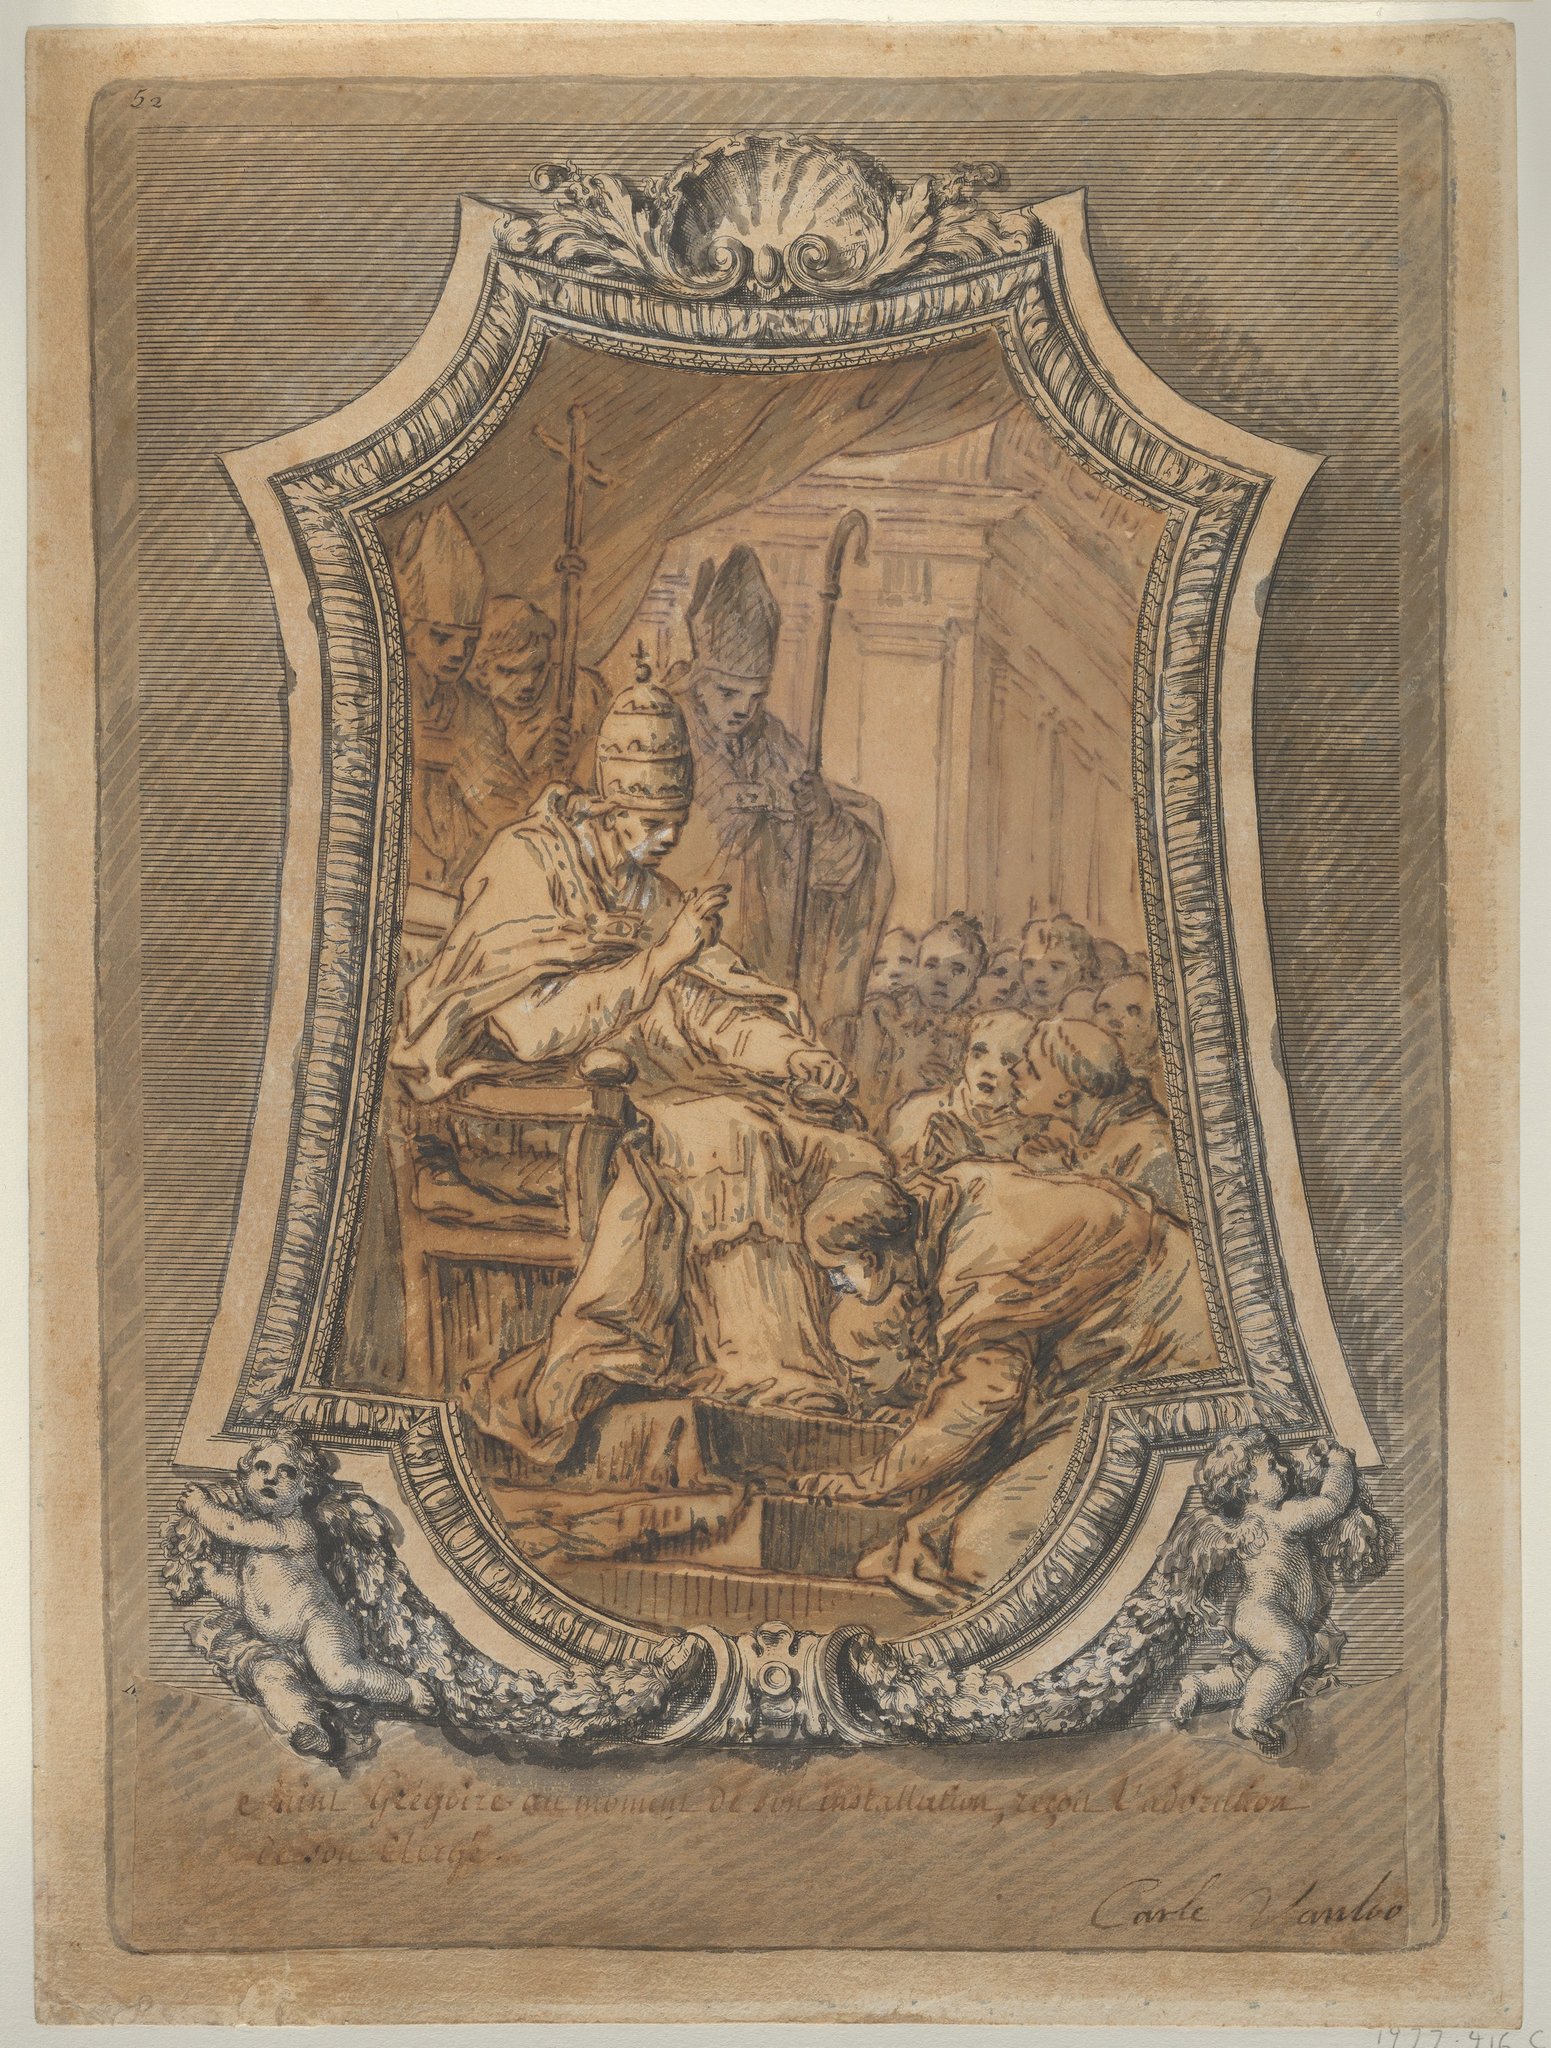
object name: drawing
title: The Clergy of Rome Paying Homage to St. Gregory after His Investiture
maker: carle (charles andré) vanloo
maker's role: artist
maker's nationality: french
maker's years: 1705-1765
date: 1701-1800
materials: graphite, ink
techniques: brush, heightening, pen, wash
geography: france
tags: human figures,cross,saints